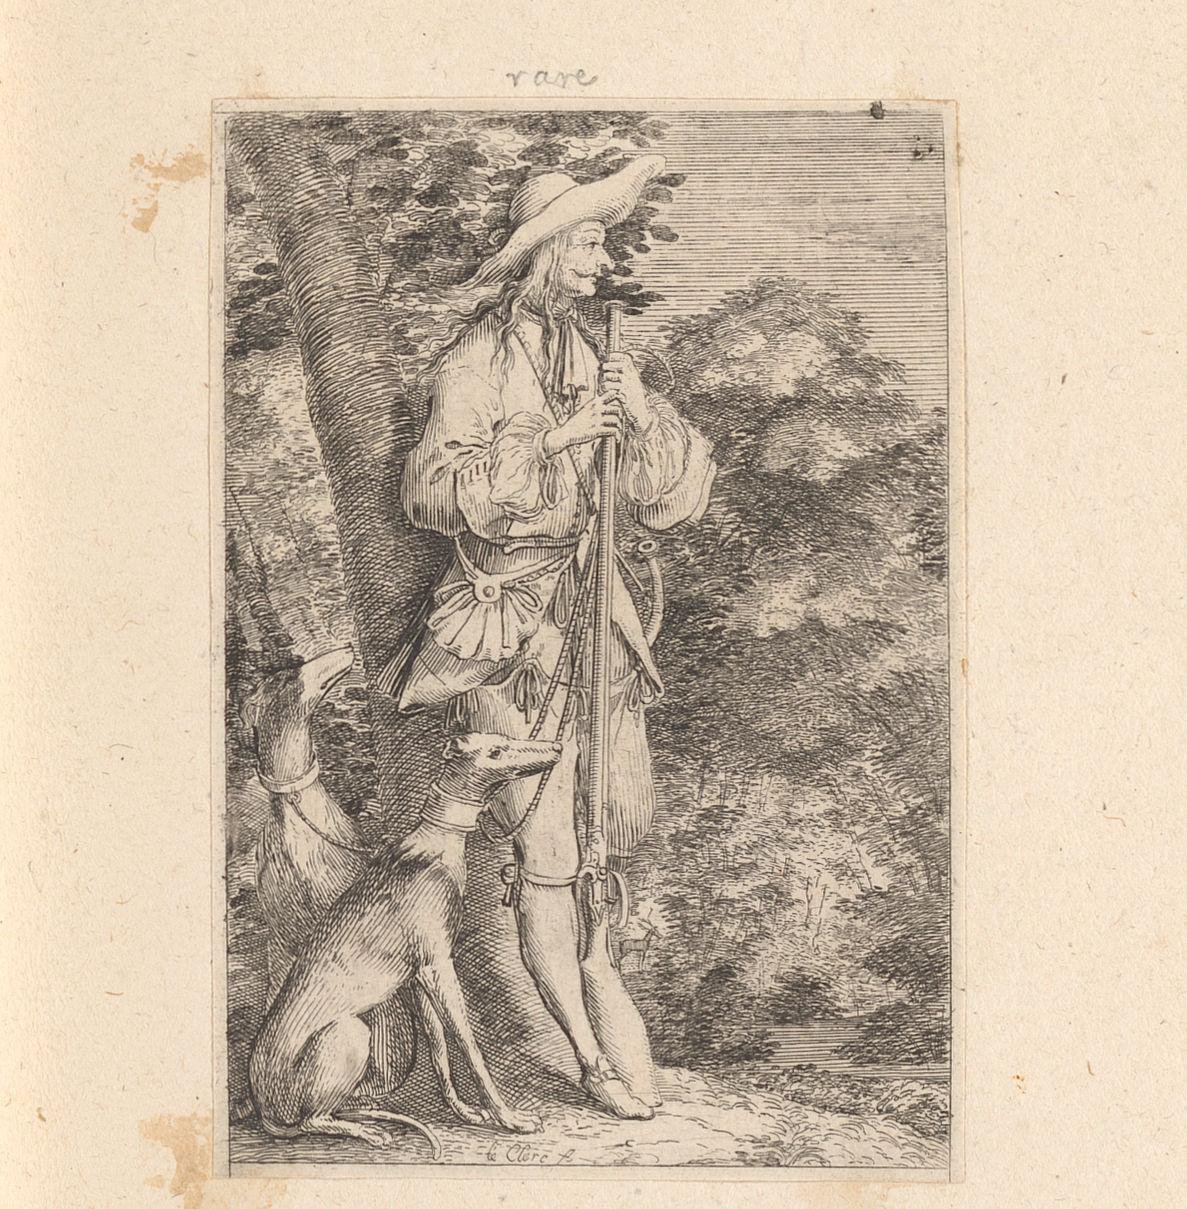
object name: album leaf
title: Les Modes de Metz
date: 1647-1701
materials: paper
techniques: engraving, etching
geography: france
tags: hunting dogs, hunter, folk costume, regional costume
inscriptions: inscription: ‘rare’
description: Prent maakt deel uit van een 28-delige serie met verschillende figuren uit Metz in de regionale mode. Leclerc vervaardigde de platen te Metz. Landry gaf slechts twintig van de prenten in een serie uit.